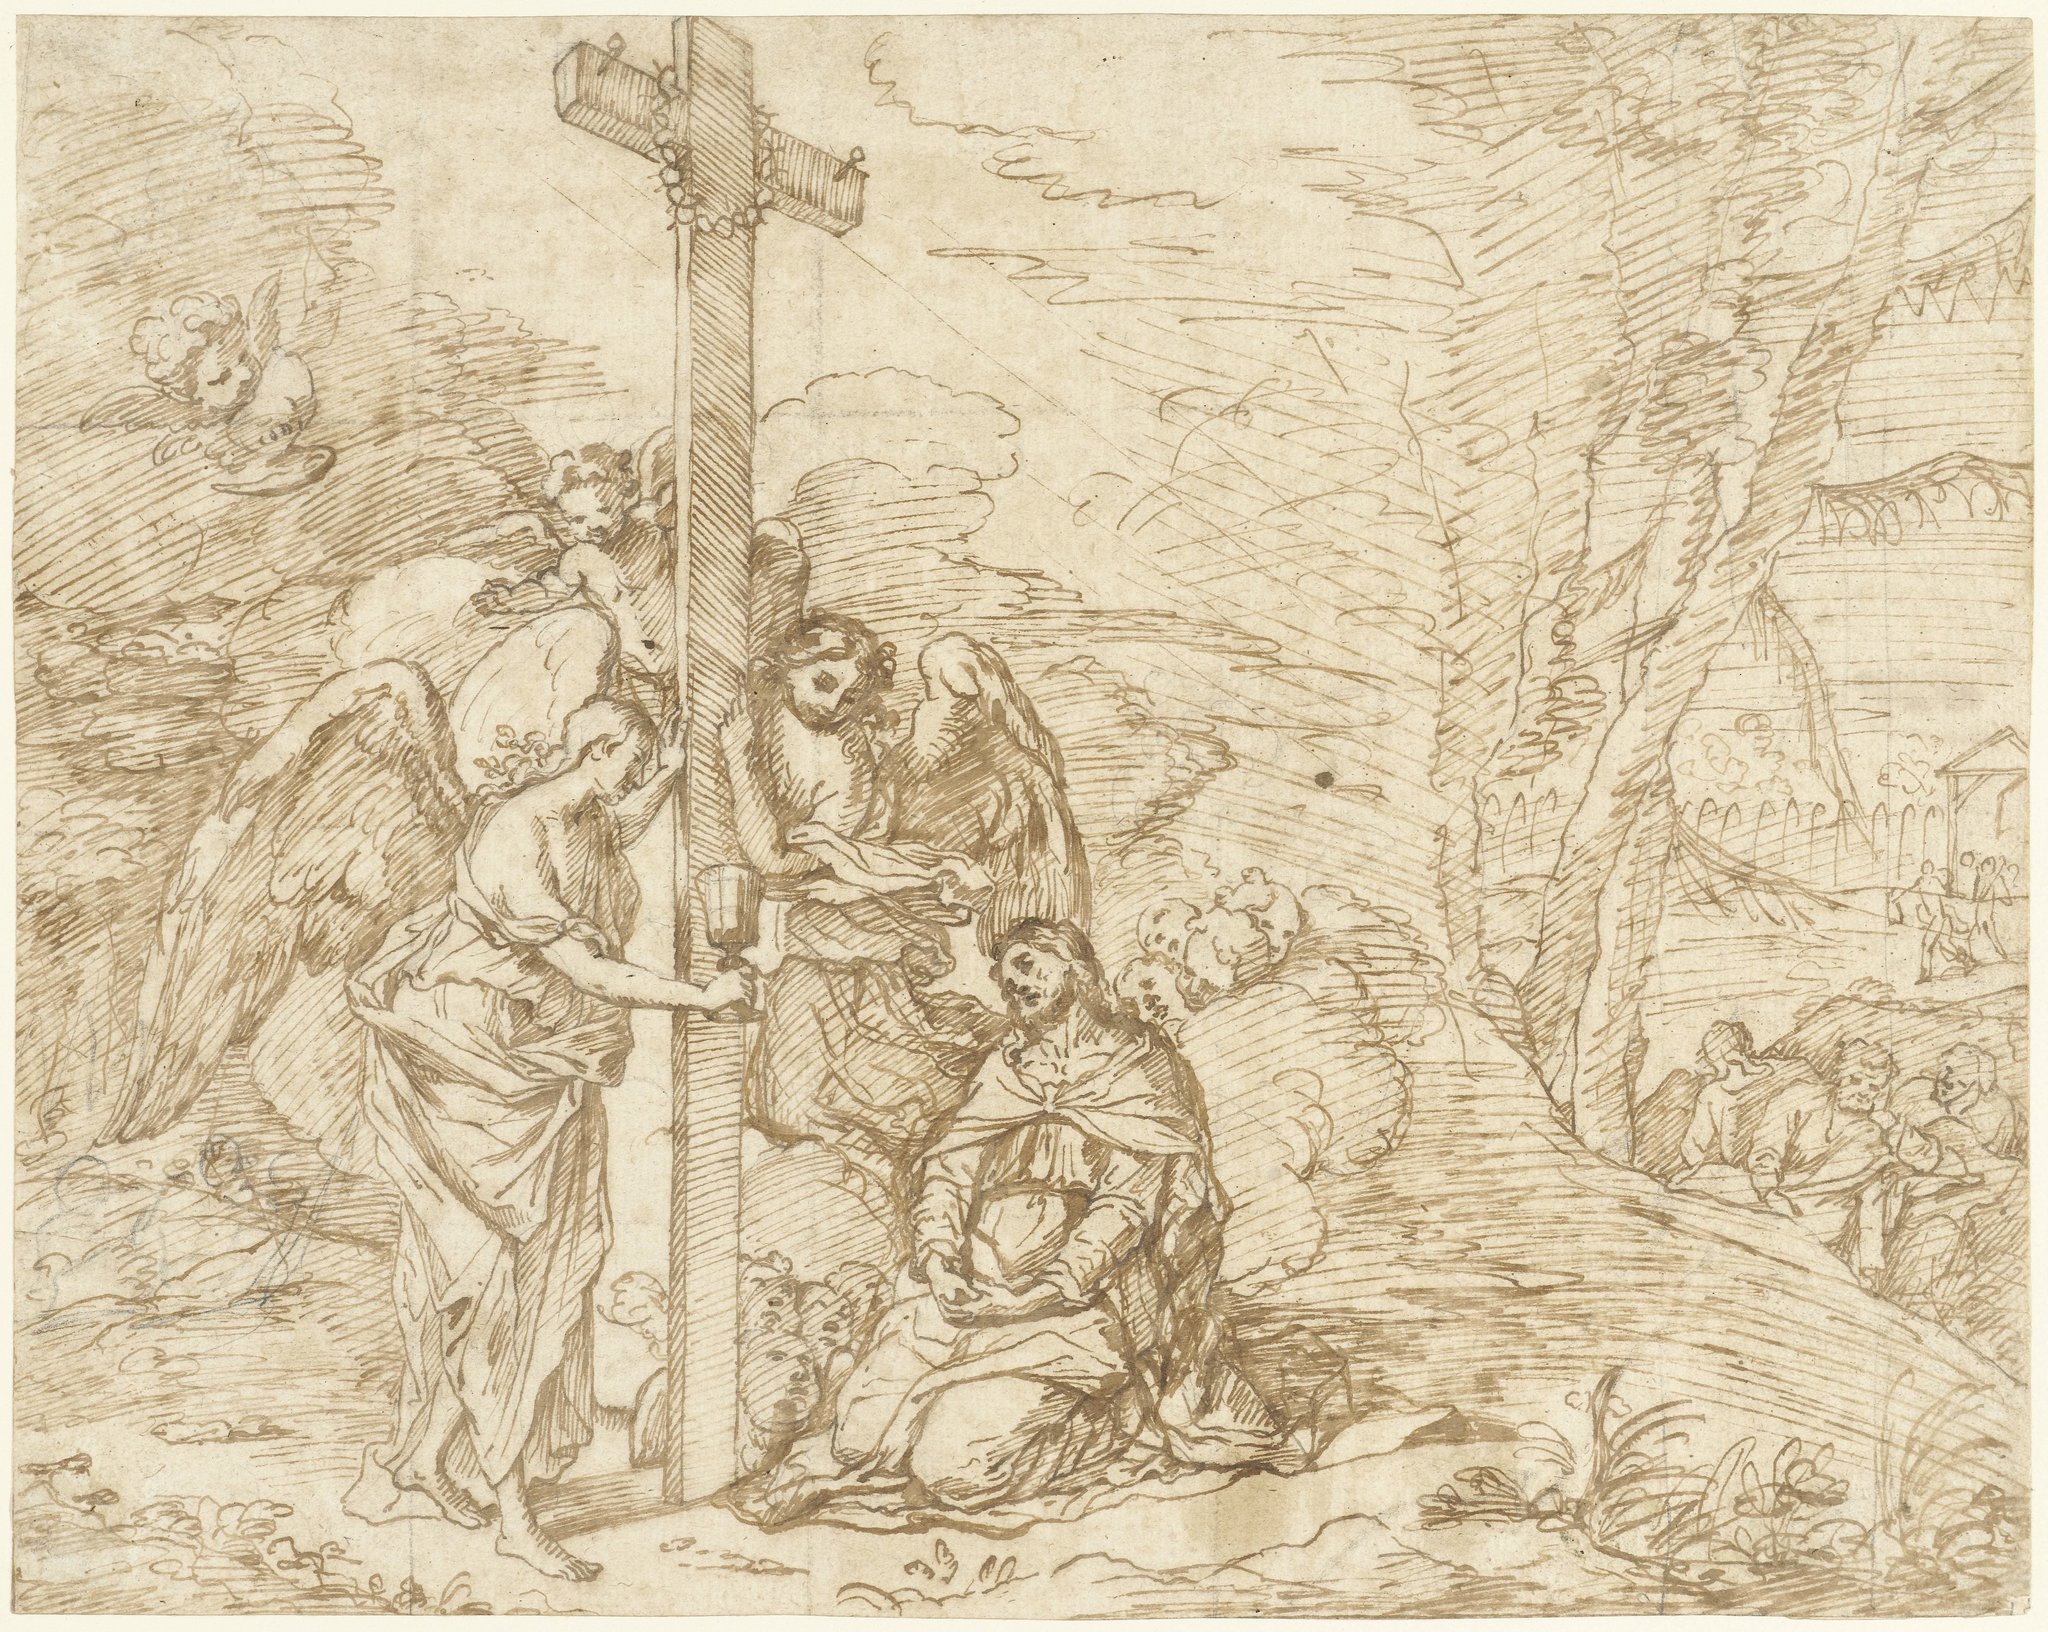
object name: drawing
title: Christus in de tuin van Gethsemane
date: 1600-1699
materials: ink, paper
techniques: pen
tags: agony of christ; three (or eleven) apostles sleeping